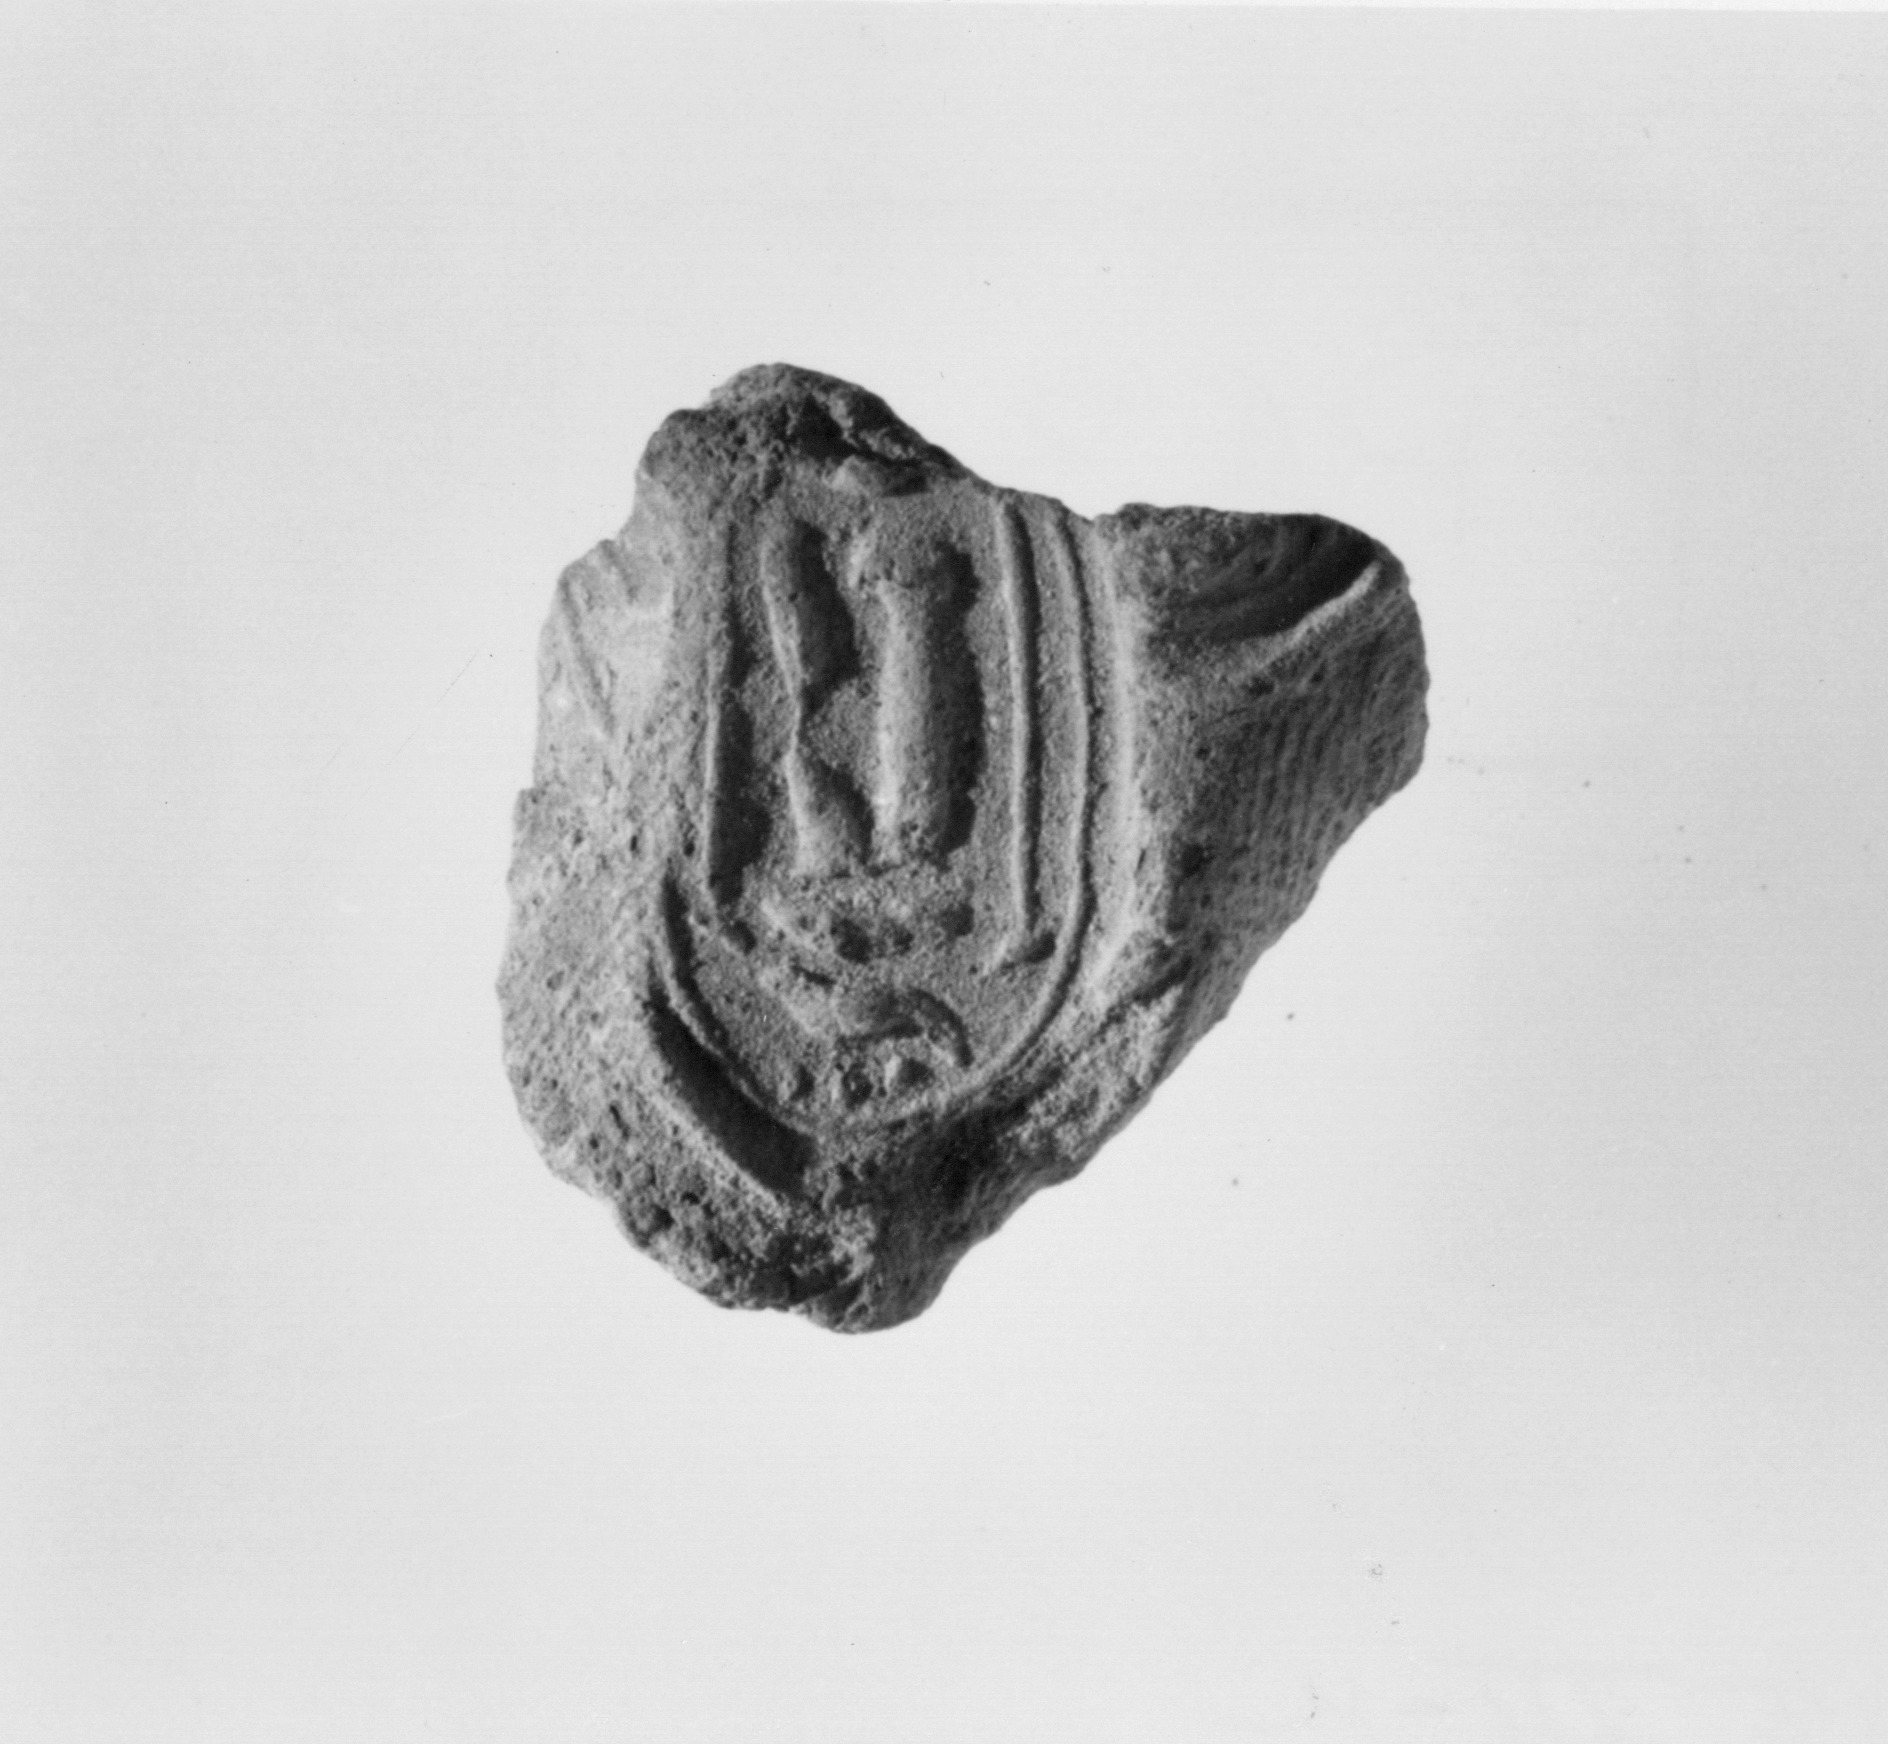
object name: sealing, nebmaatre, amenhotep iii,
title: Document Sealing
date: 1390-1352 BCE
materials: mud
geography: egypt